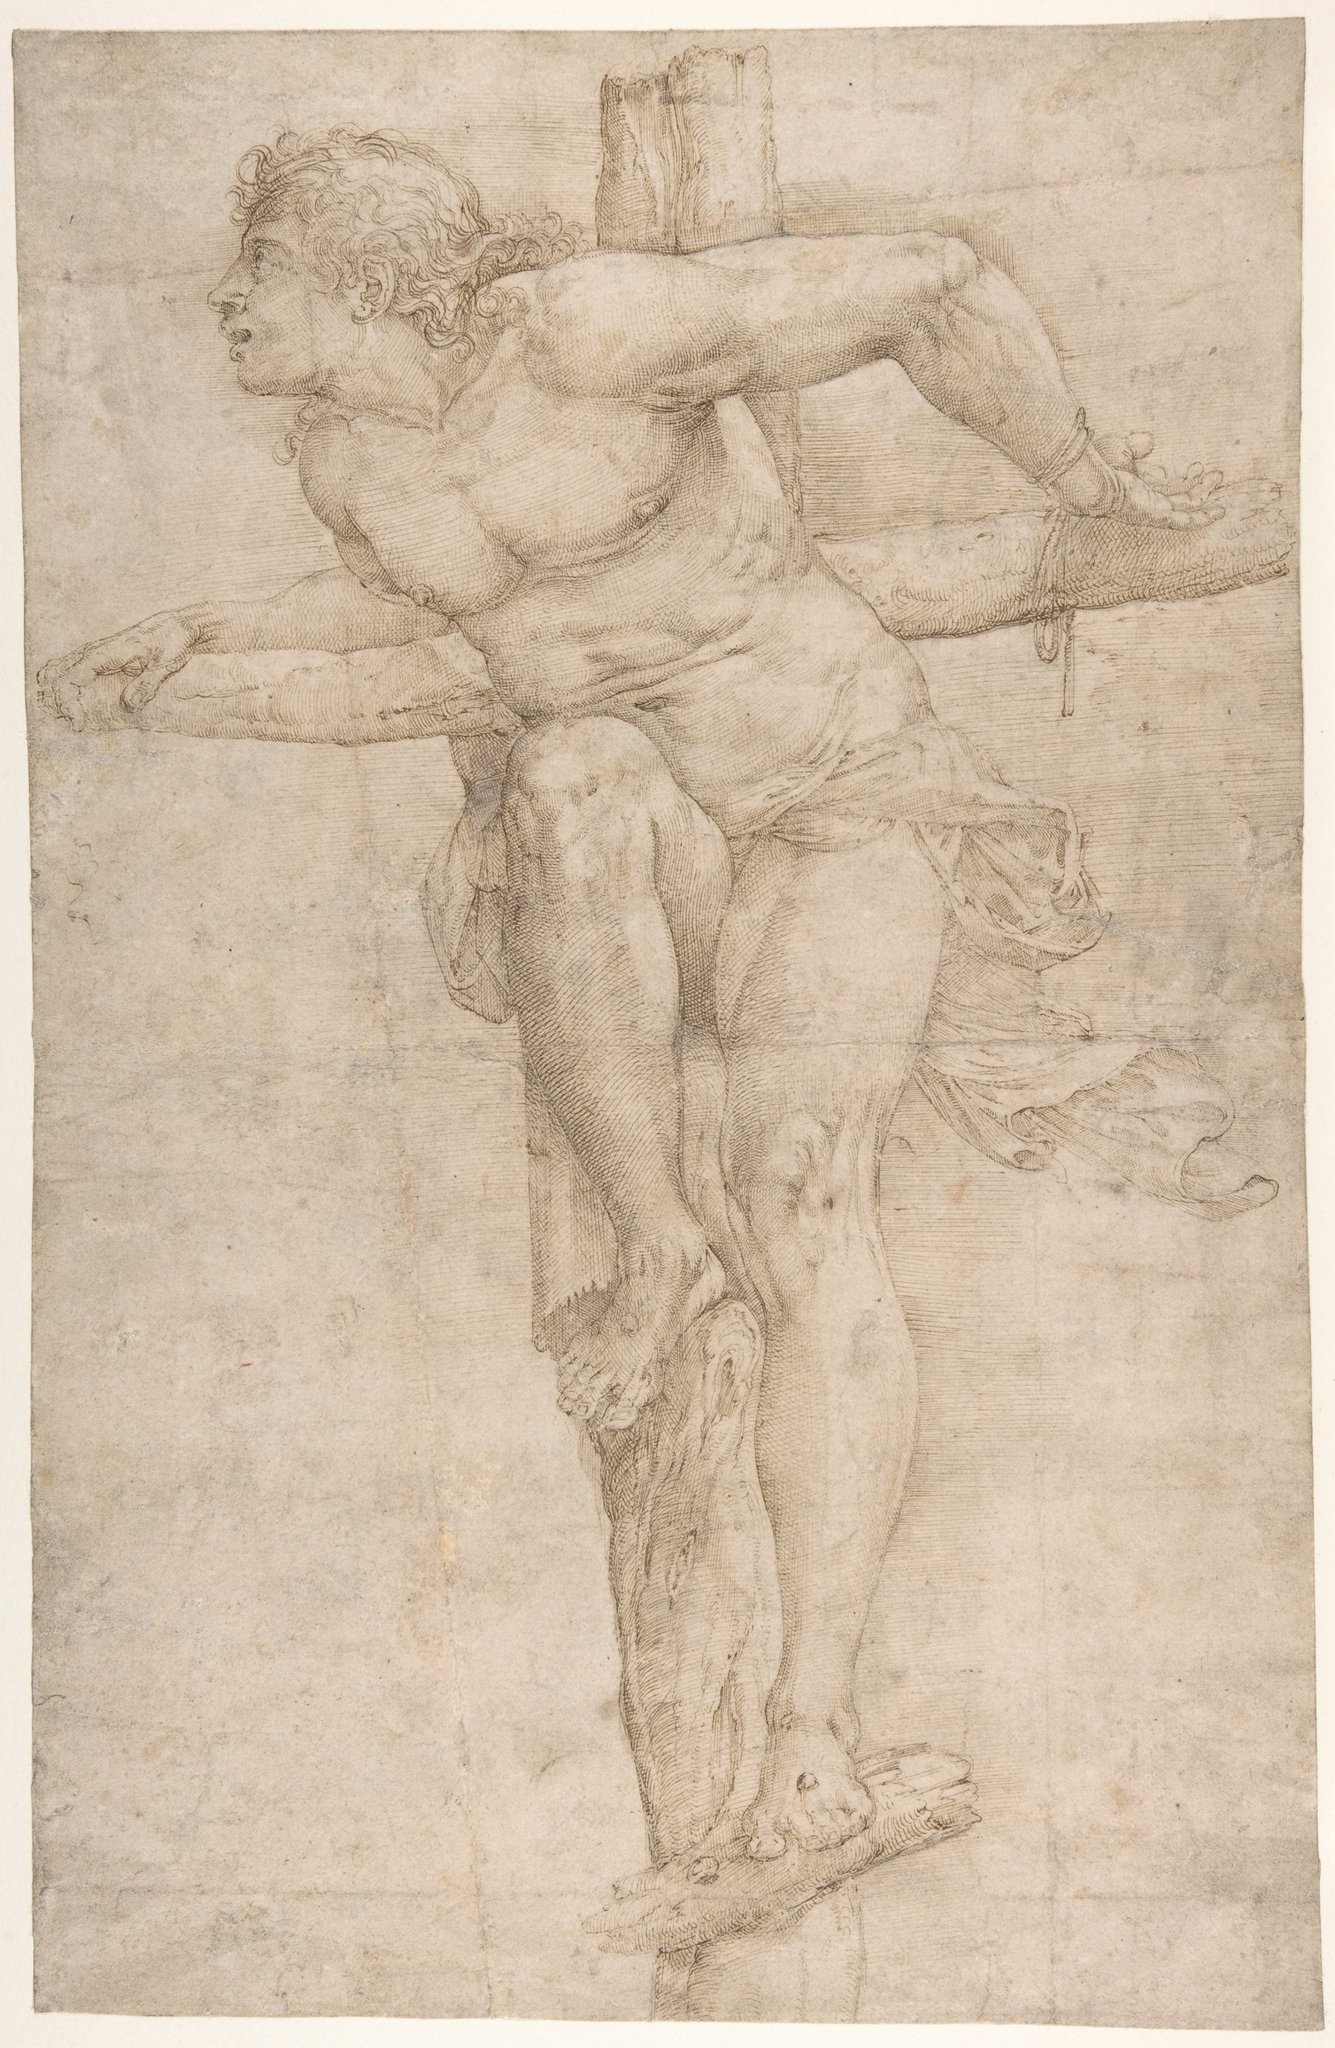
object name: drawing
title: The Penitent Thief on the Cross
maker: battista franco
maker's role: artist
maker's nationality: italian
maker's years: 1510-1561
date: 1510-1561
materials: ink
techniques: incising, pen, transfer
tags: men,cross